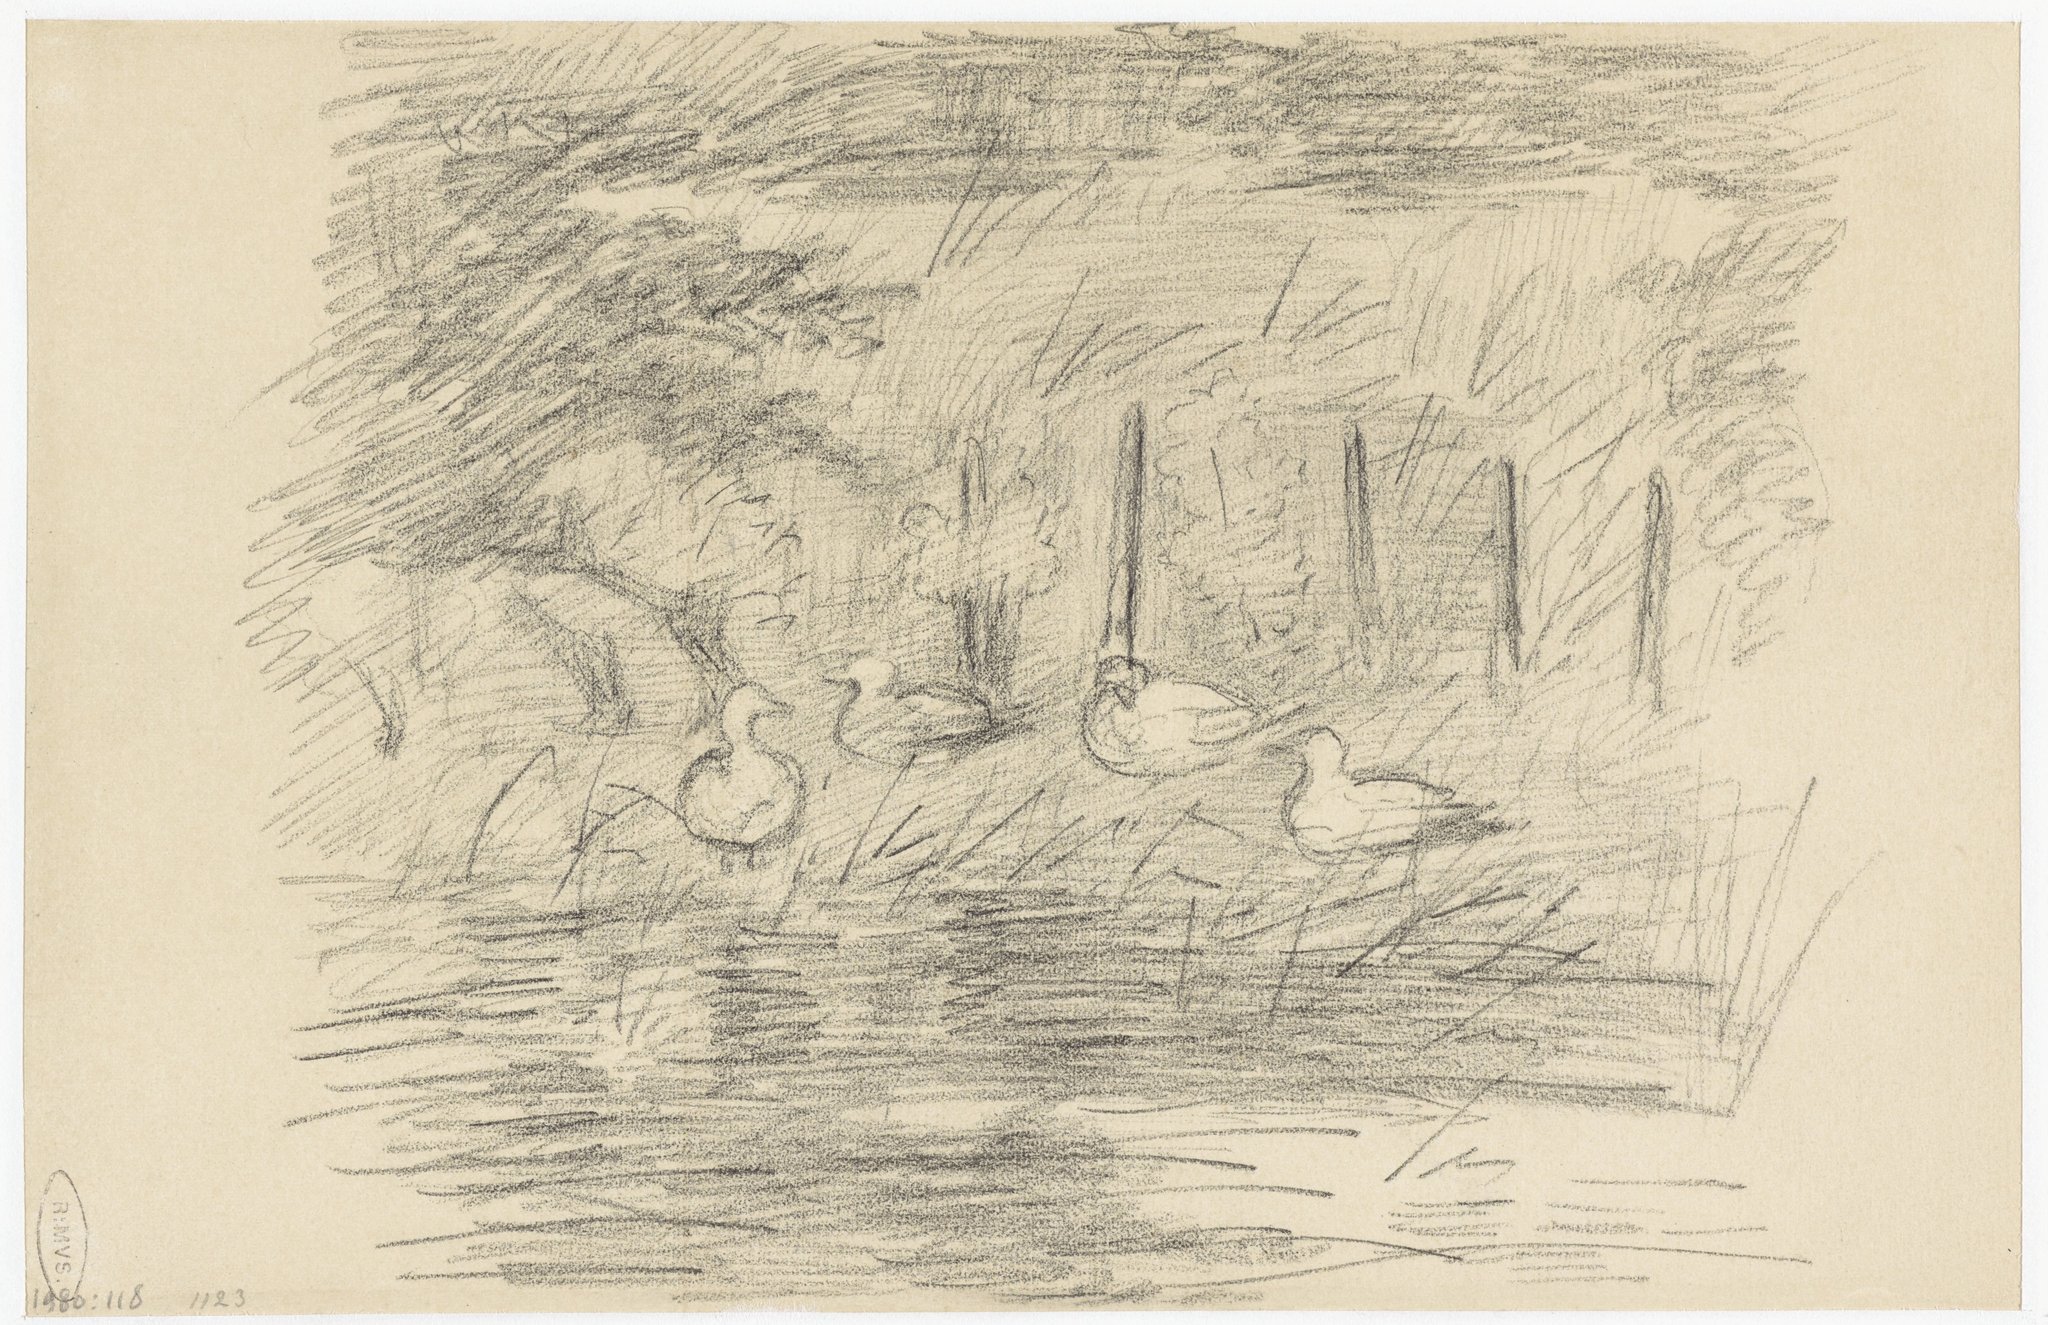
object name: drawing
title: Vier eenden op de oever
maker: jozef israëls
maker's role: draughtsman, painter, print maker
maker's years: 1824-1911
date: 1834-1911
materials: chalk, paper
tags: domestic waterbirds